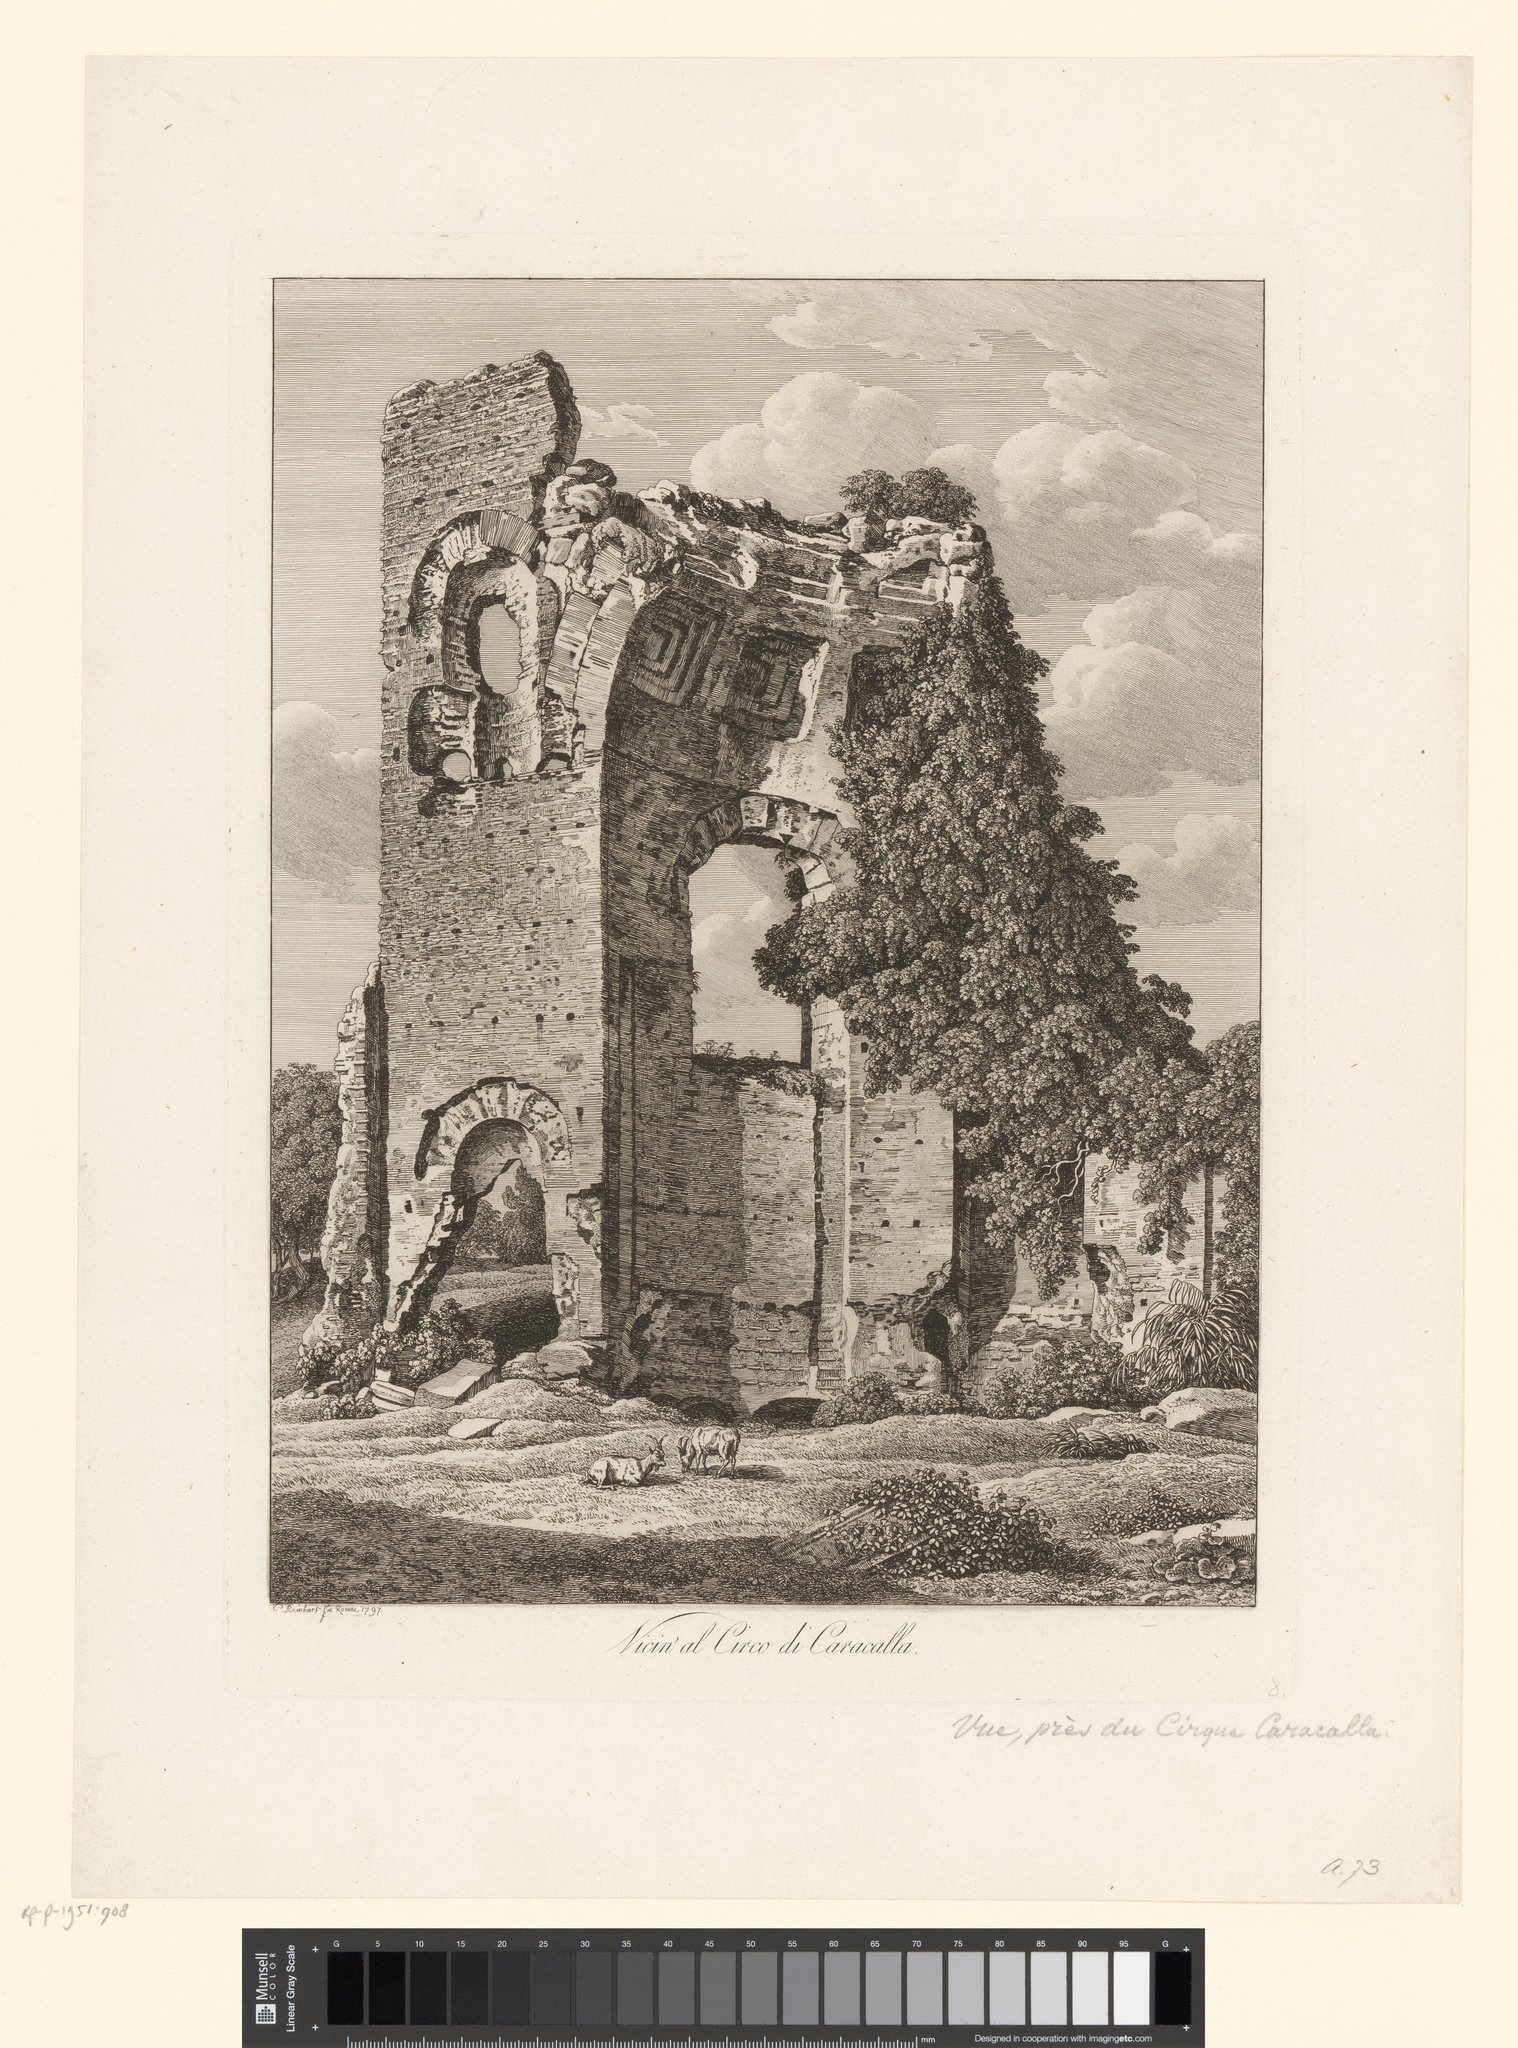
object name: print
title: Italiaanse landschappen met monumenten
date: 1797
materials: paper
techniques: engraving, etching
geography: nuremberg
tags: landscapes, landscape with monument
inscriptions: collector's mark: Lugt 2228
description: Behorend tot een serie van 72 'Mahlerisch-radirte Prospecte von Italien', waarvoor de kunstenaar 24 prenten maakte. Albert Christoph Dies (1755-1822) en Jacob Wilhelm Mechau (1745-1808) maakten eveneens 24 platen, in opdracht van Jean Fréderic Frauenholz. Vanaf 1792 verschenen telkens drie sets van twee prenten per kunstenaar. In 1798 werd de laatste set uitgegeven, waarna complete sets gebonden werden uitgegeven tot in 1875 (Nuerenberg: J.L. Lotzbeck). Zie: Schmid, F.C., A.C. Dies, J.W. Mechau und J.C. Reinhart 'Mahlerische radirte Prospecte von Italien' (...). Berlijn: s.n., 1991.